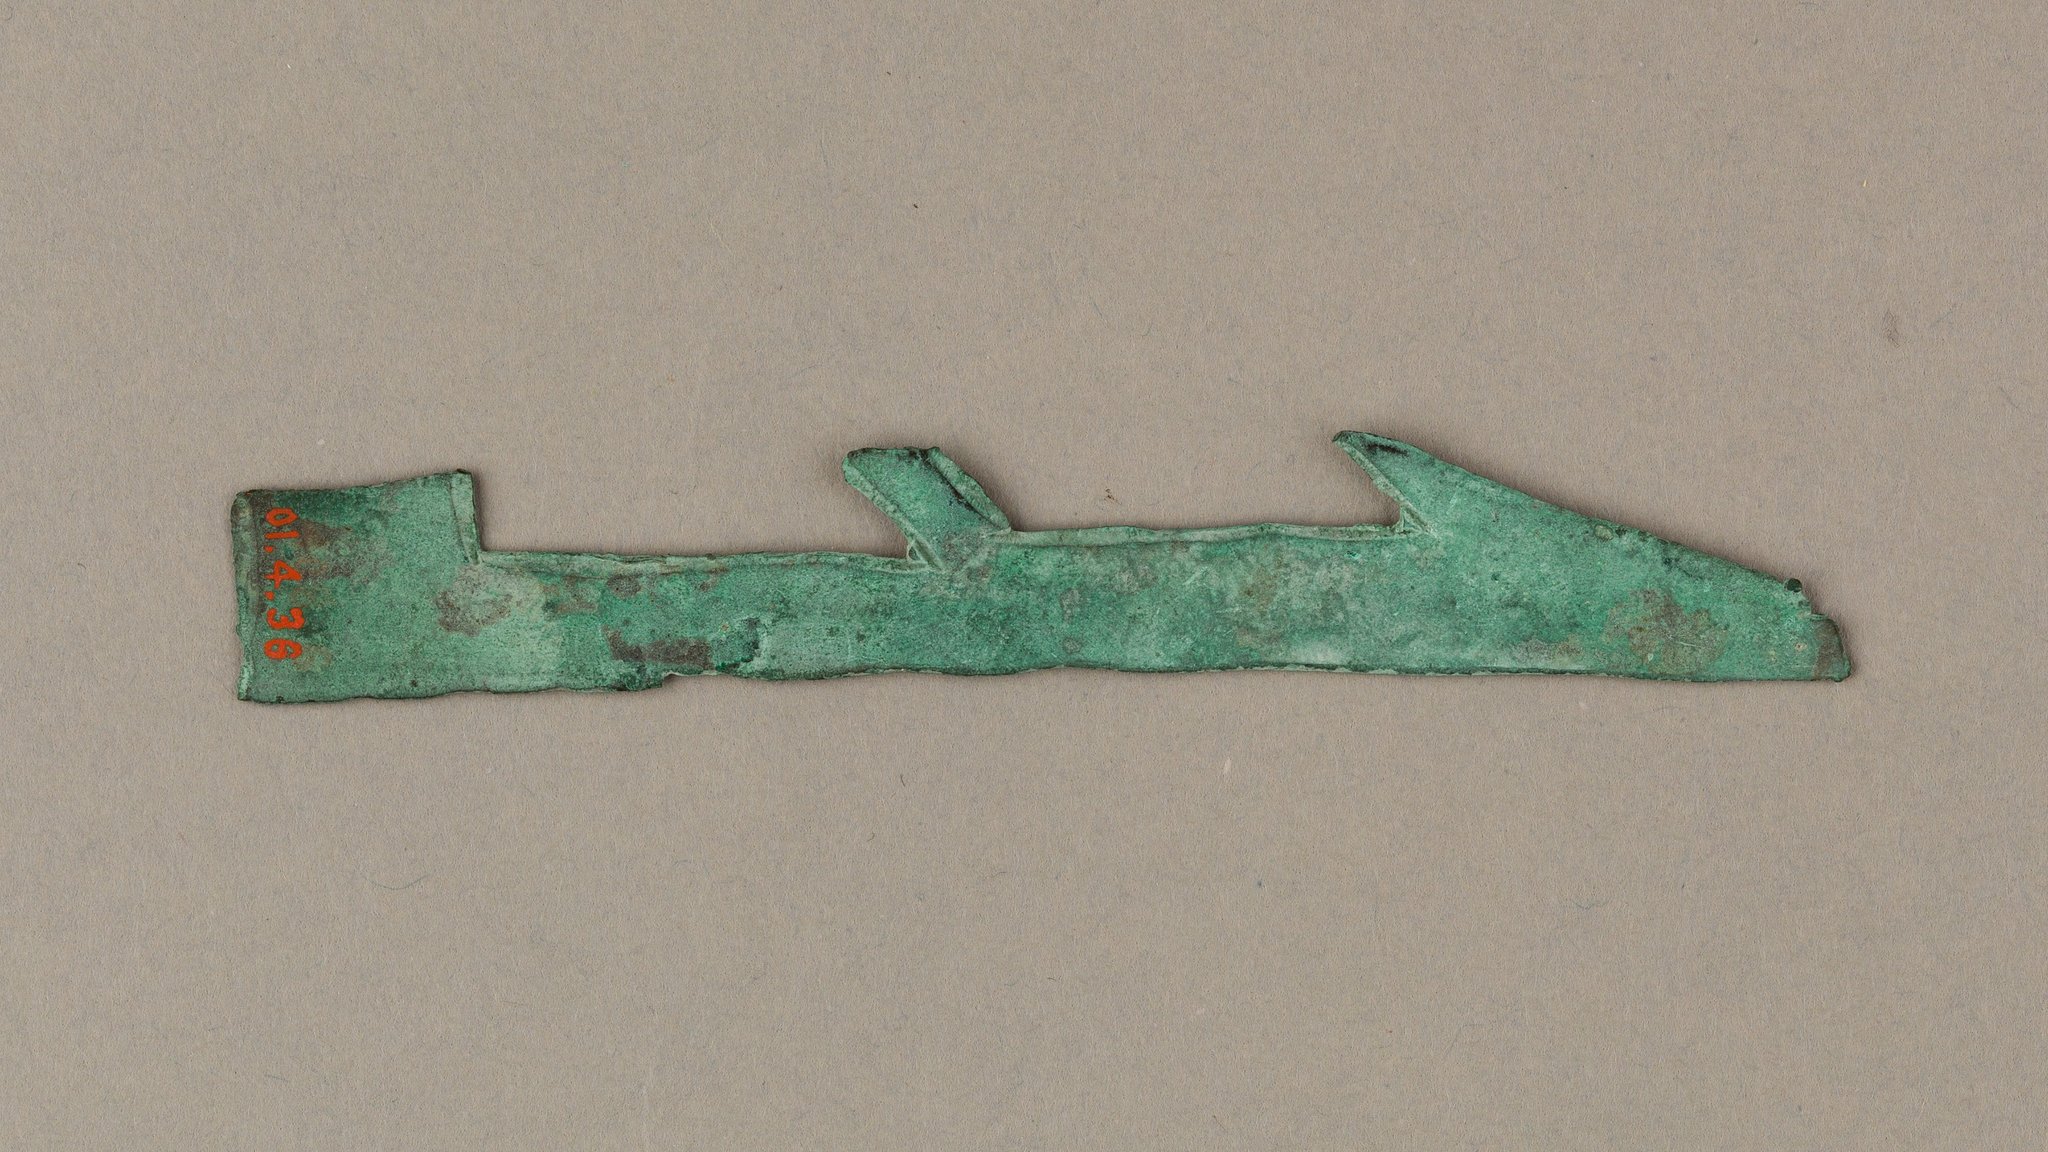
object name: model harpoon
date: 2650 BCE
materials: copper alloy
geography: egypt